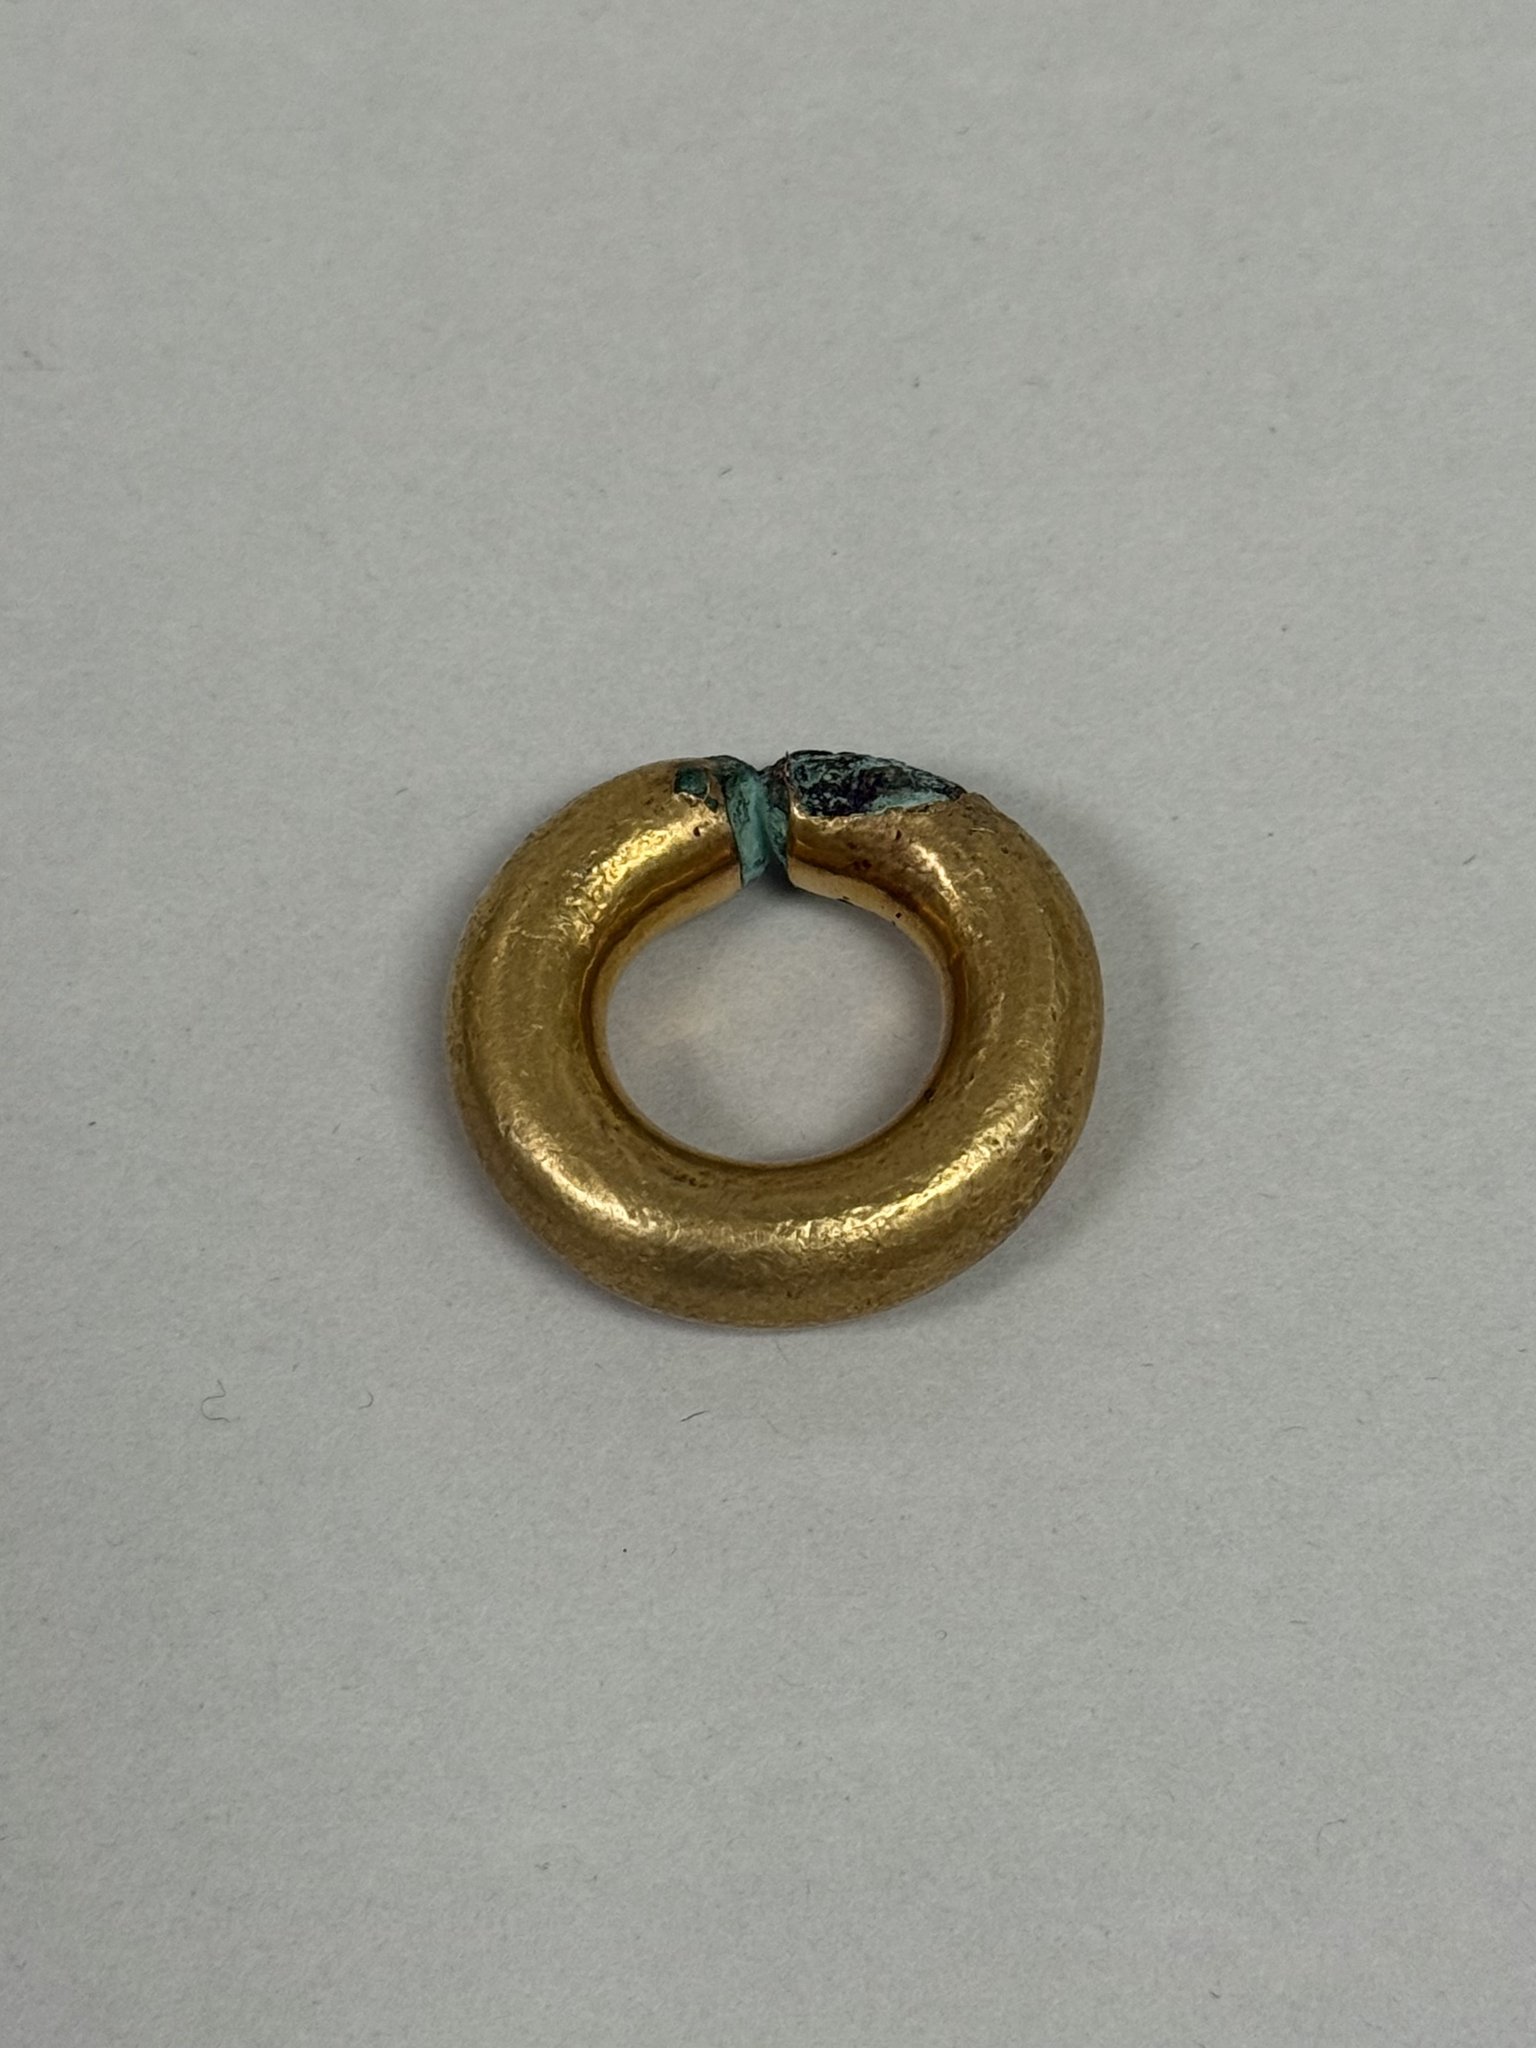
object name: earring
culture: japanese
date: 501-600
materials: copper gilt